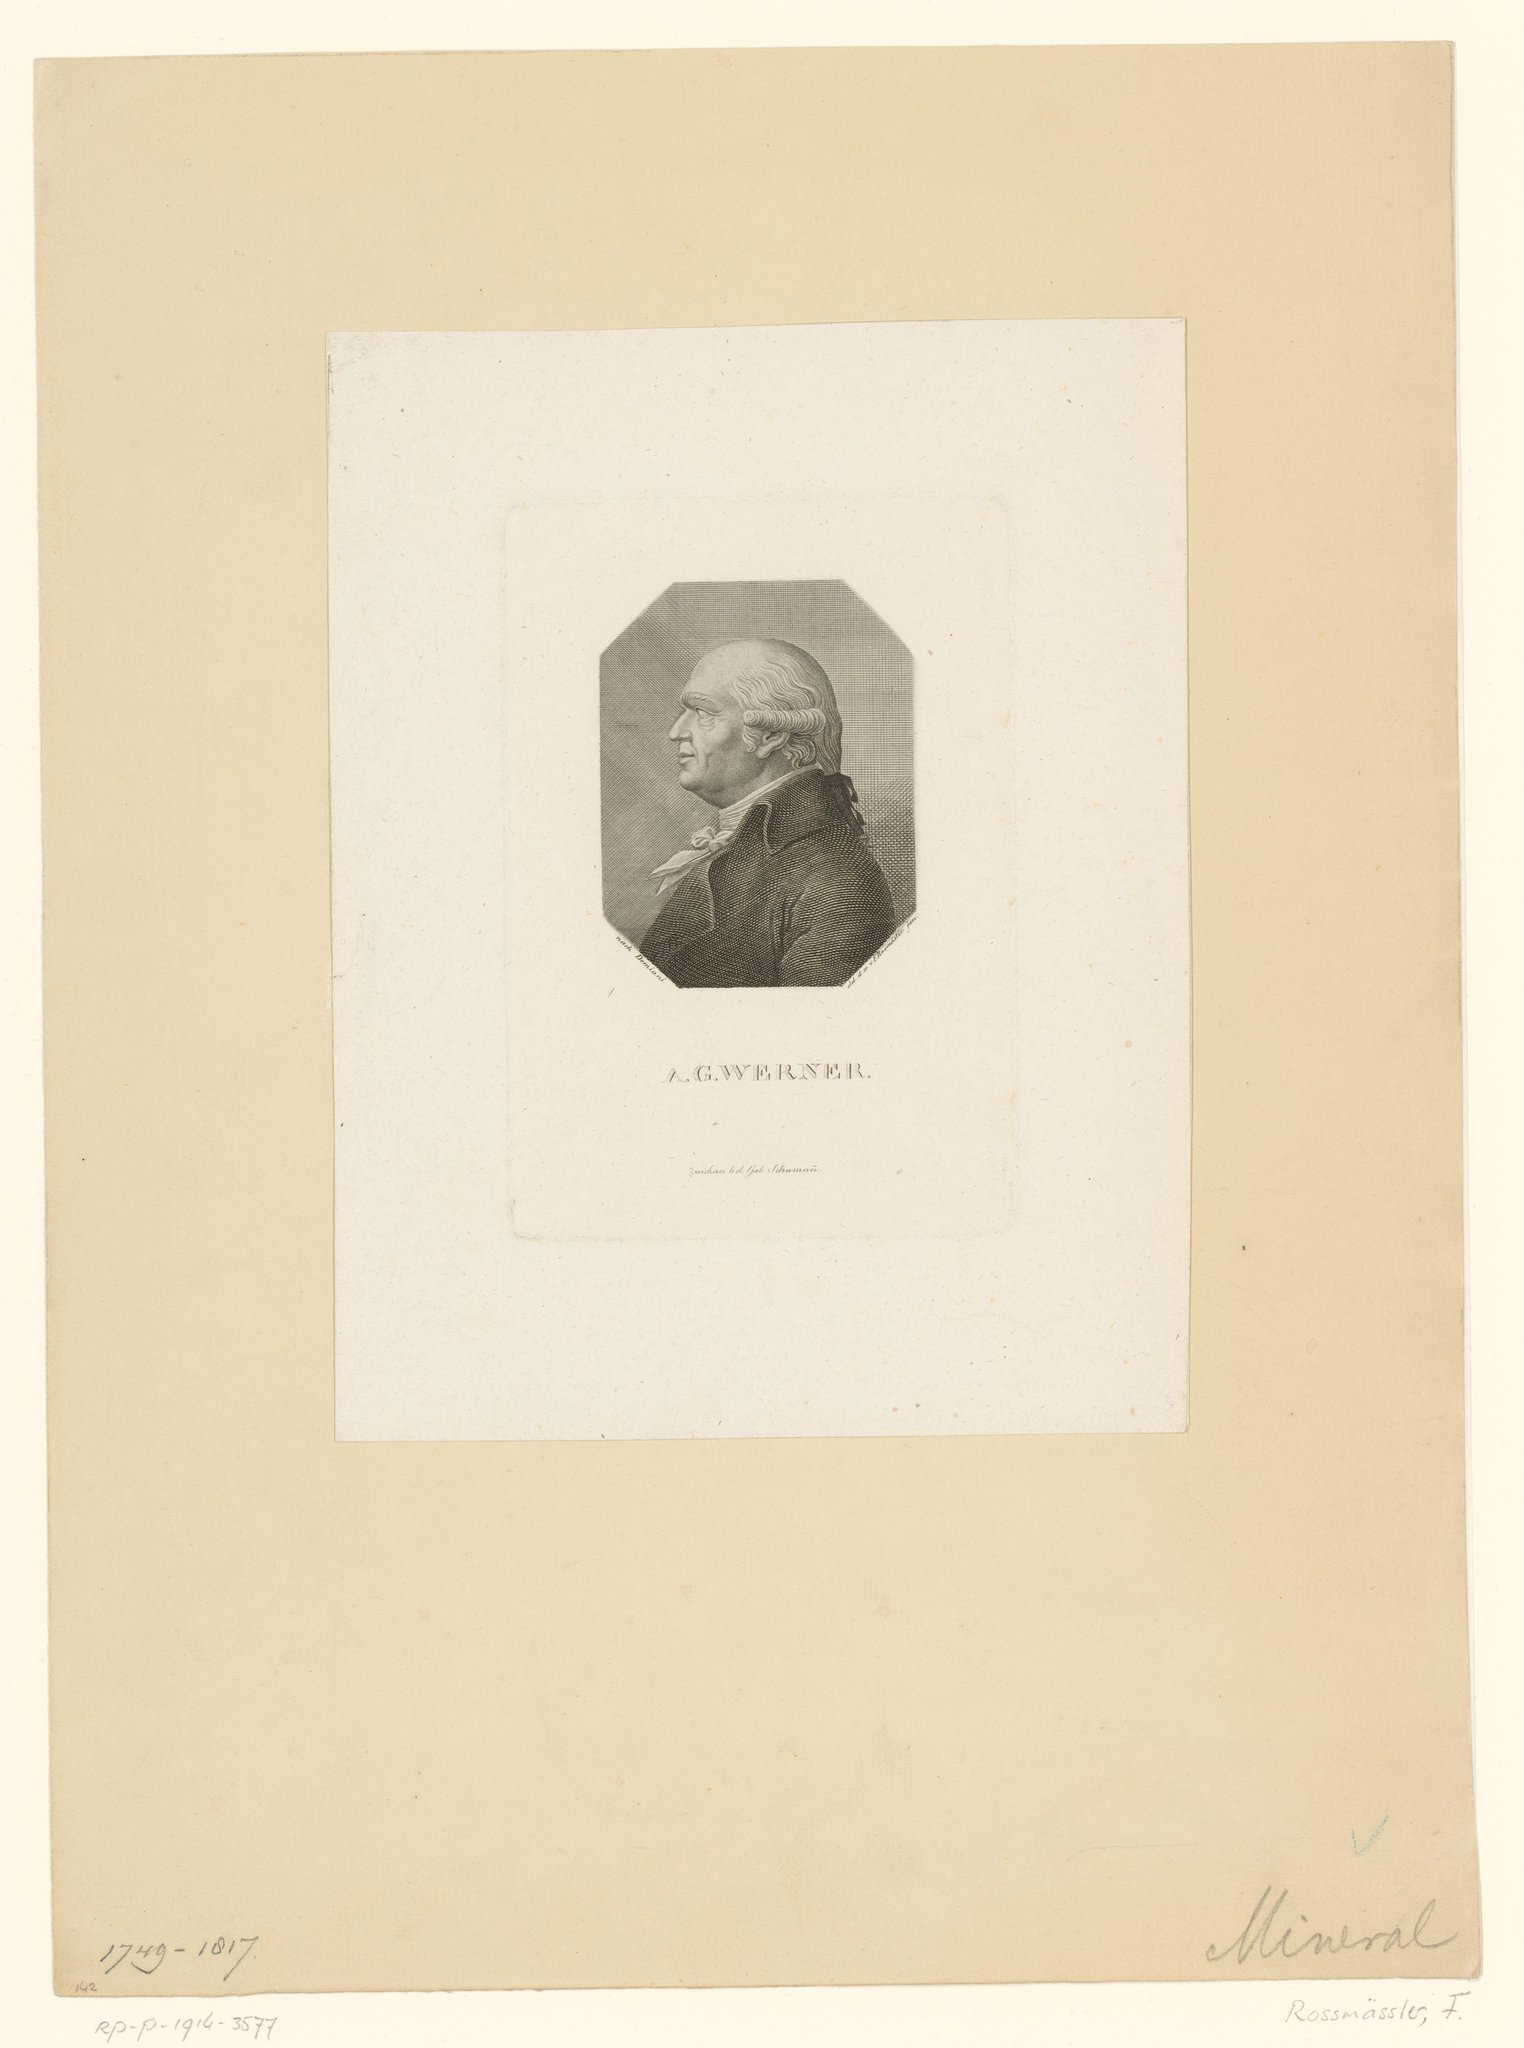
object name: print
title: Portret van Abraham Gottlob Werner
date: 1785-1858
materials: paper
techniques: engraving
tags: historical persons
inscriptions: collector's mark: Lugt 2228